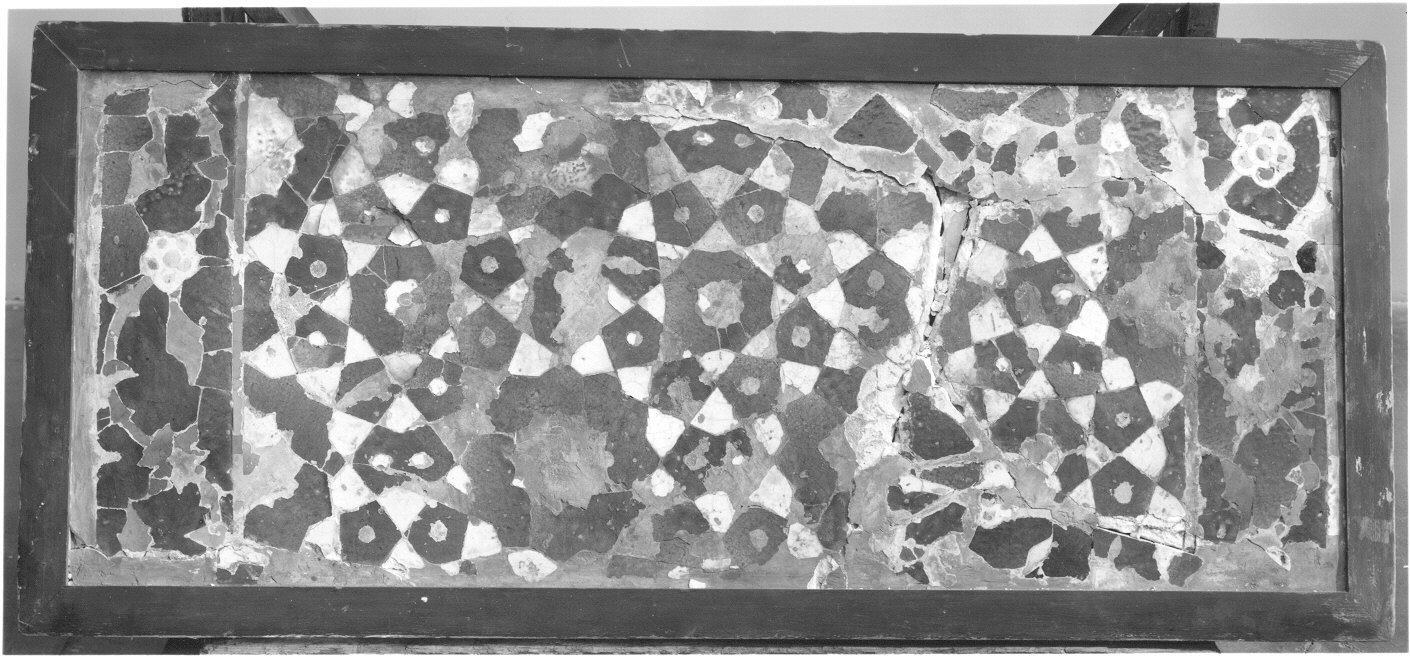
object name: tile panel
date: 1601-1700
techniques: glazing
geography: iran